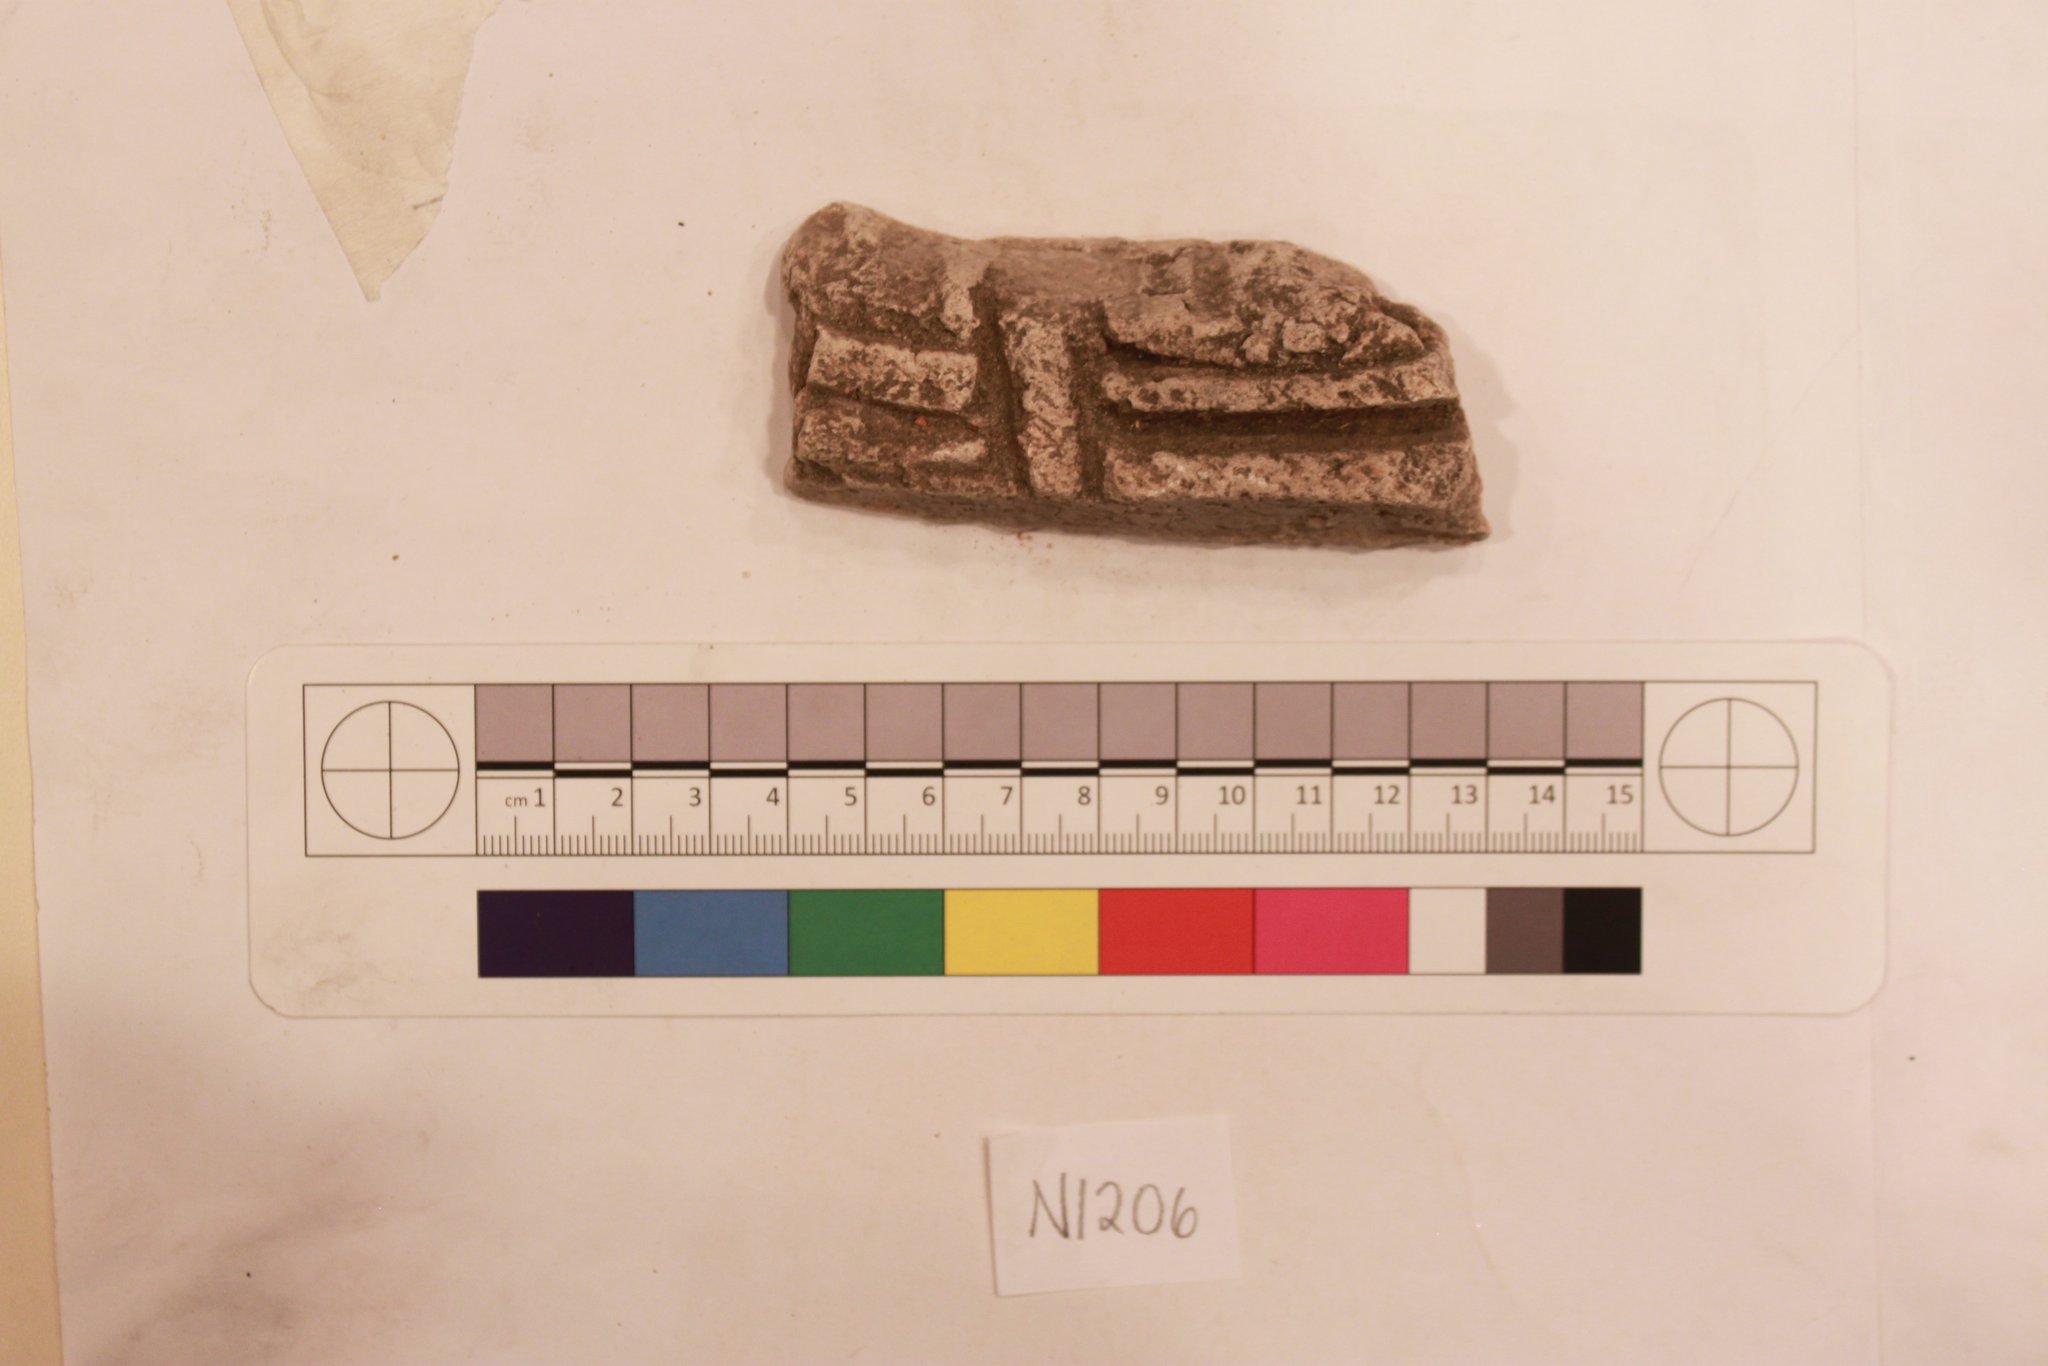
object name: fragment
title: Stucco Fragment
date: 701-1200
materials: plaster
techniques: carving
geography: iran